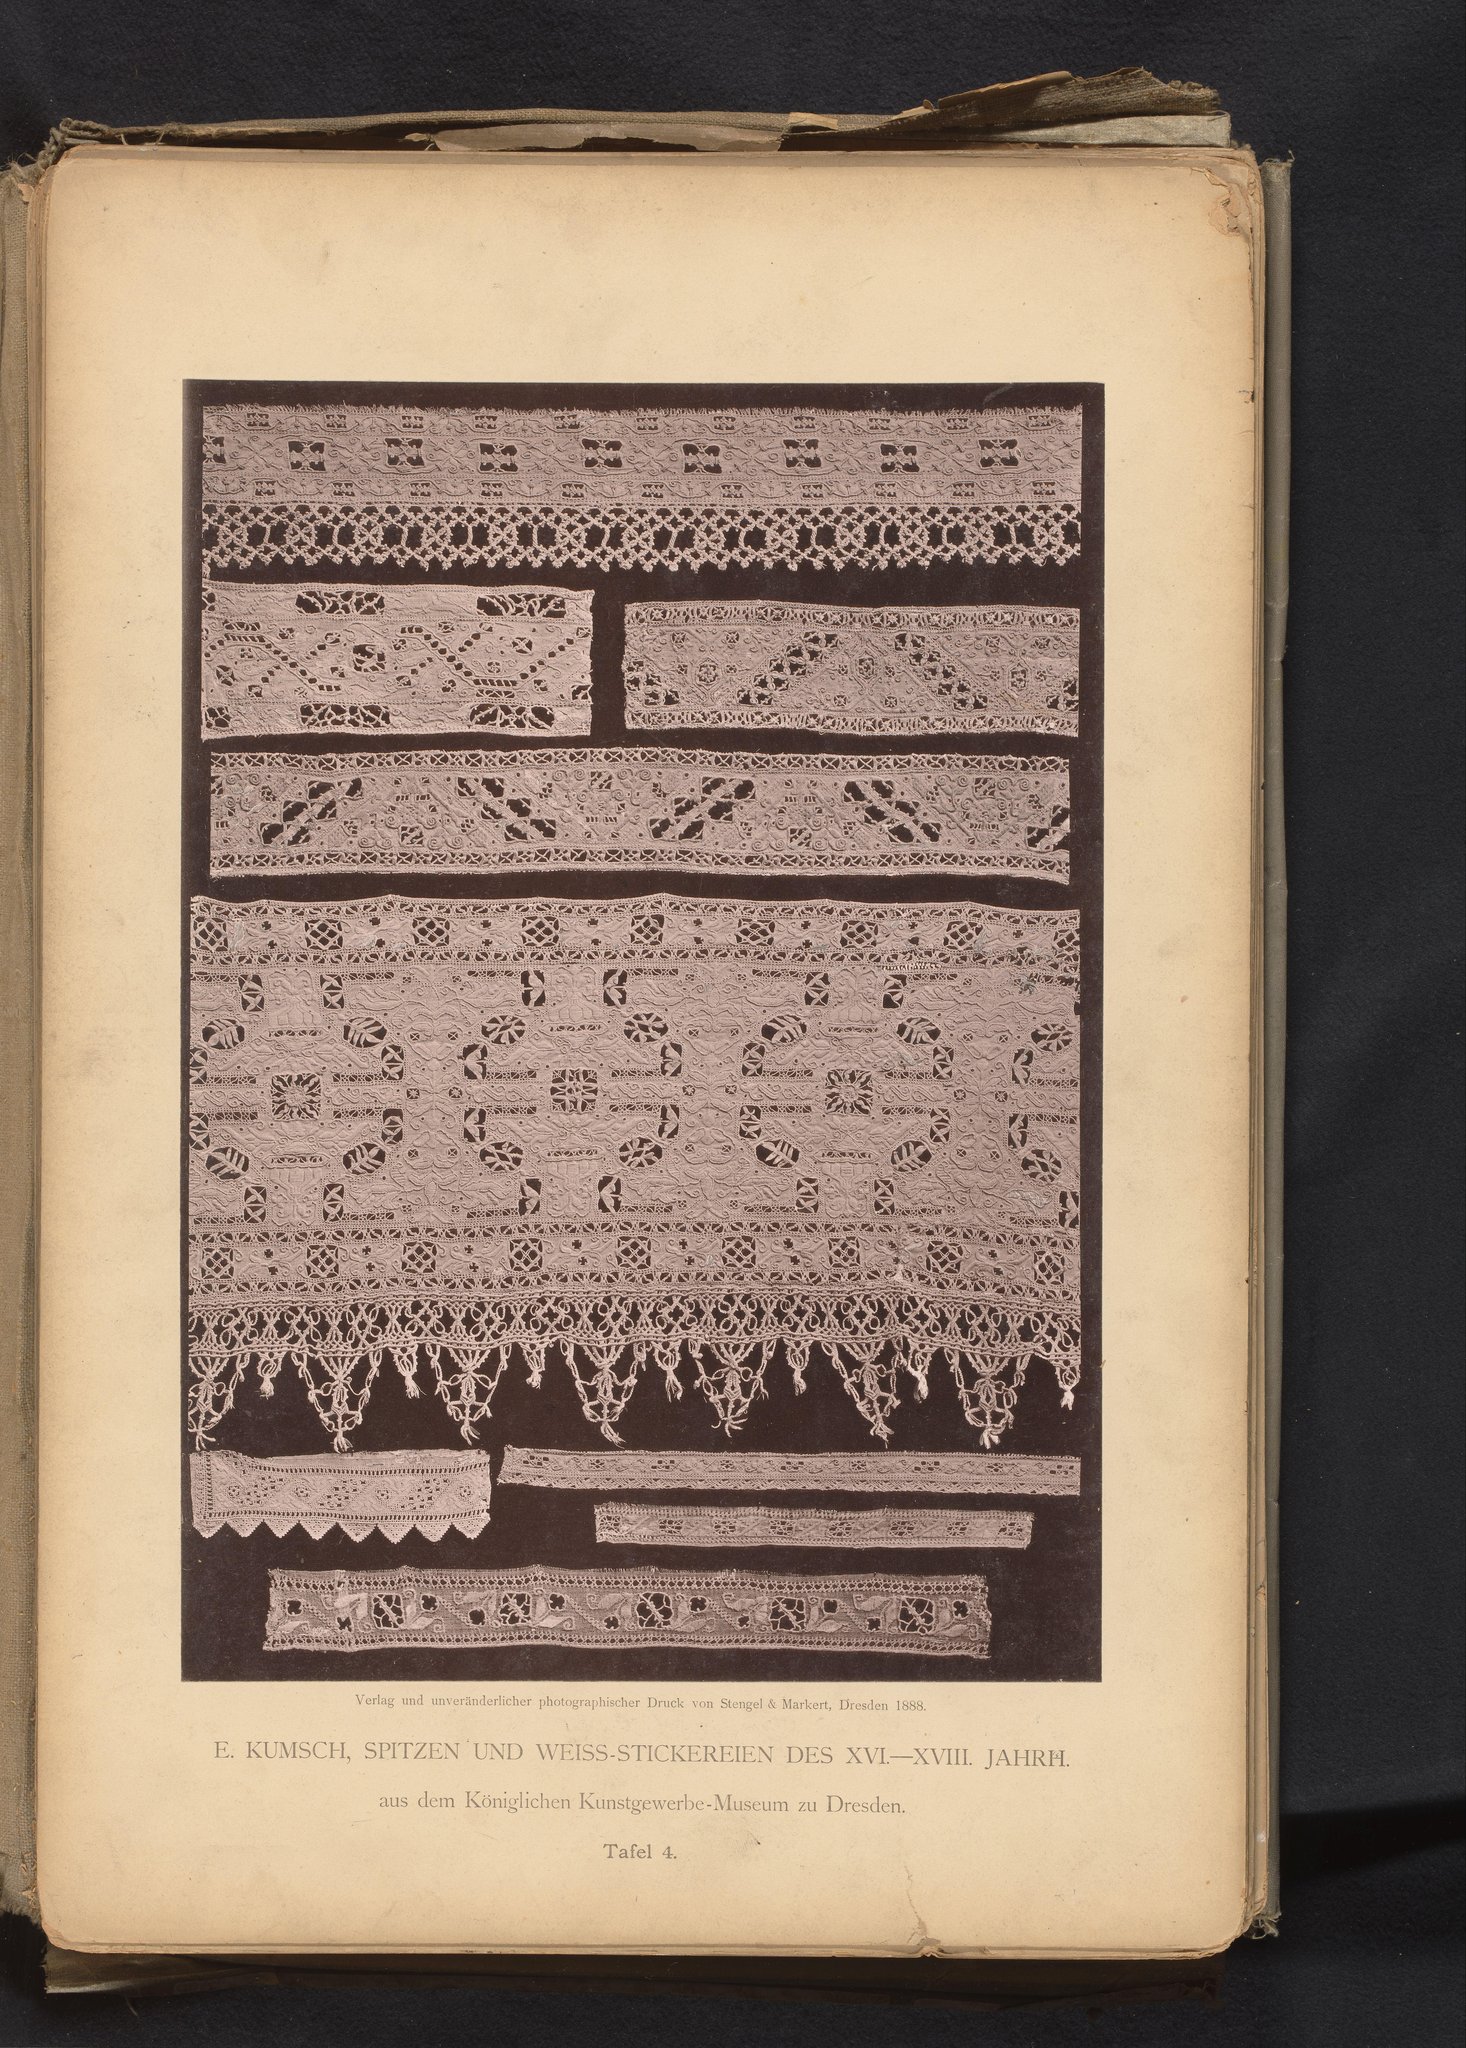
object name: photomechanical print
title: Negen stukken Italiaans kant uit circa 1620, uit de collectie van het Kunstgewerbemuseum in Dresden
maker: Anonymous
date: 1888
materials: paper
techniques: photograph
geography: dresden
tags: lace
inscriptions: inscription: ‘E. KUMSCH, SPITZEN UND WEISS-STICKEREIEN DES XVI.-XVIII. JAHRH./ aus dem Königlichen Kunstgewerbe-Museum zu Dresden’, number: ‘Tafel 4.’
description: Deze prent maakt deel uit van een omslag met 49 prenten en een lijst van afbeeldingen.